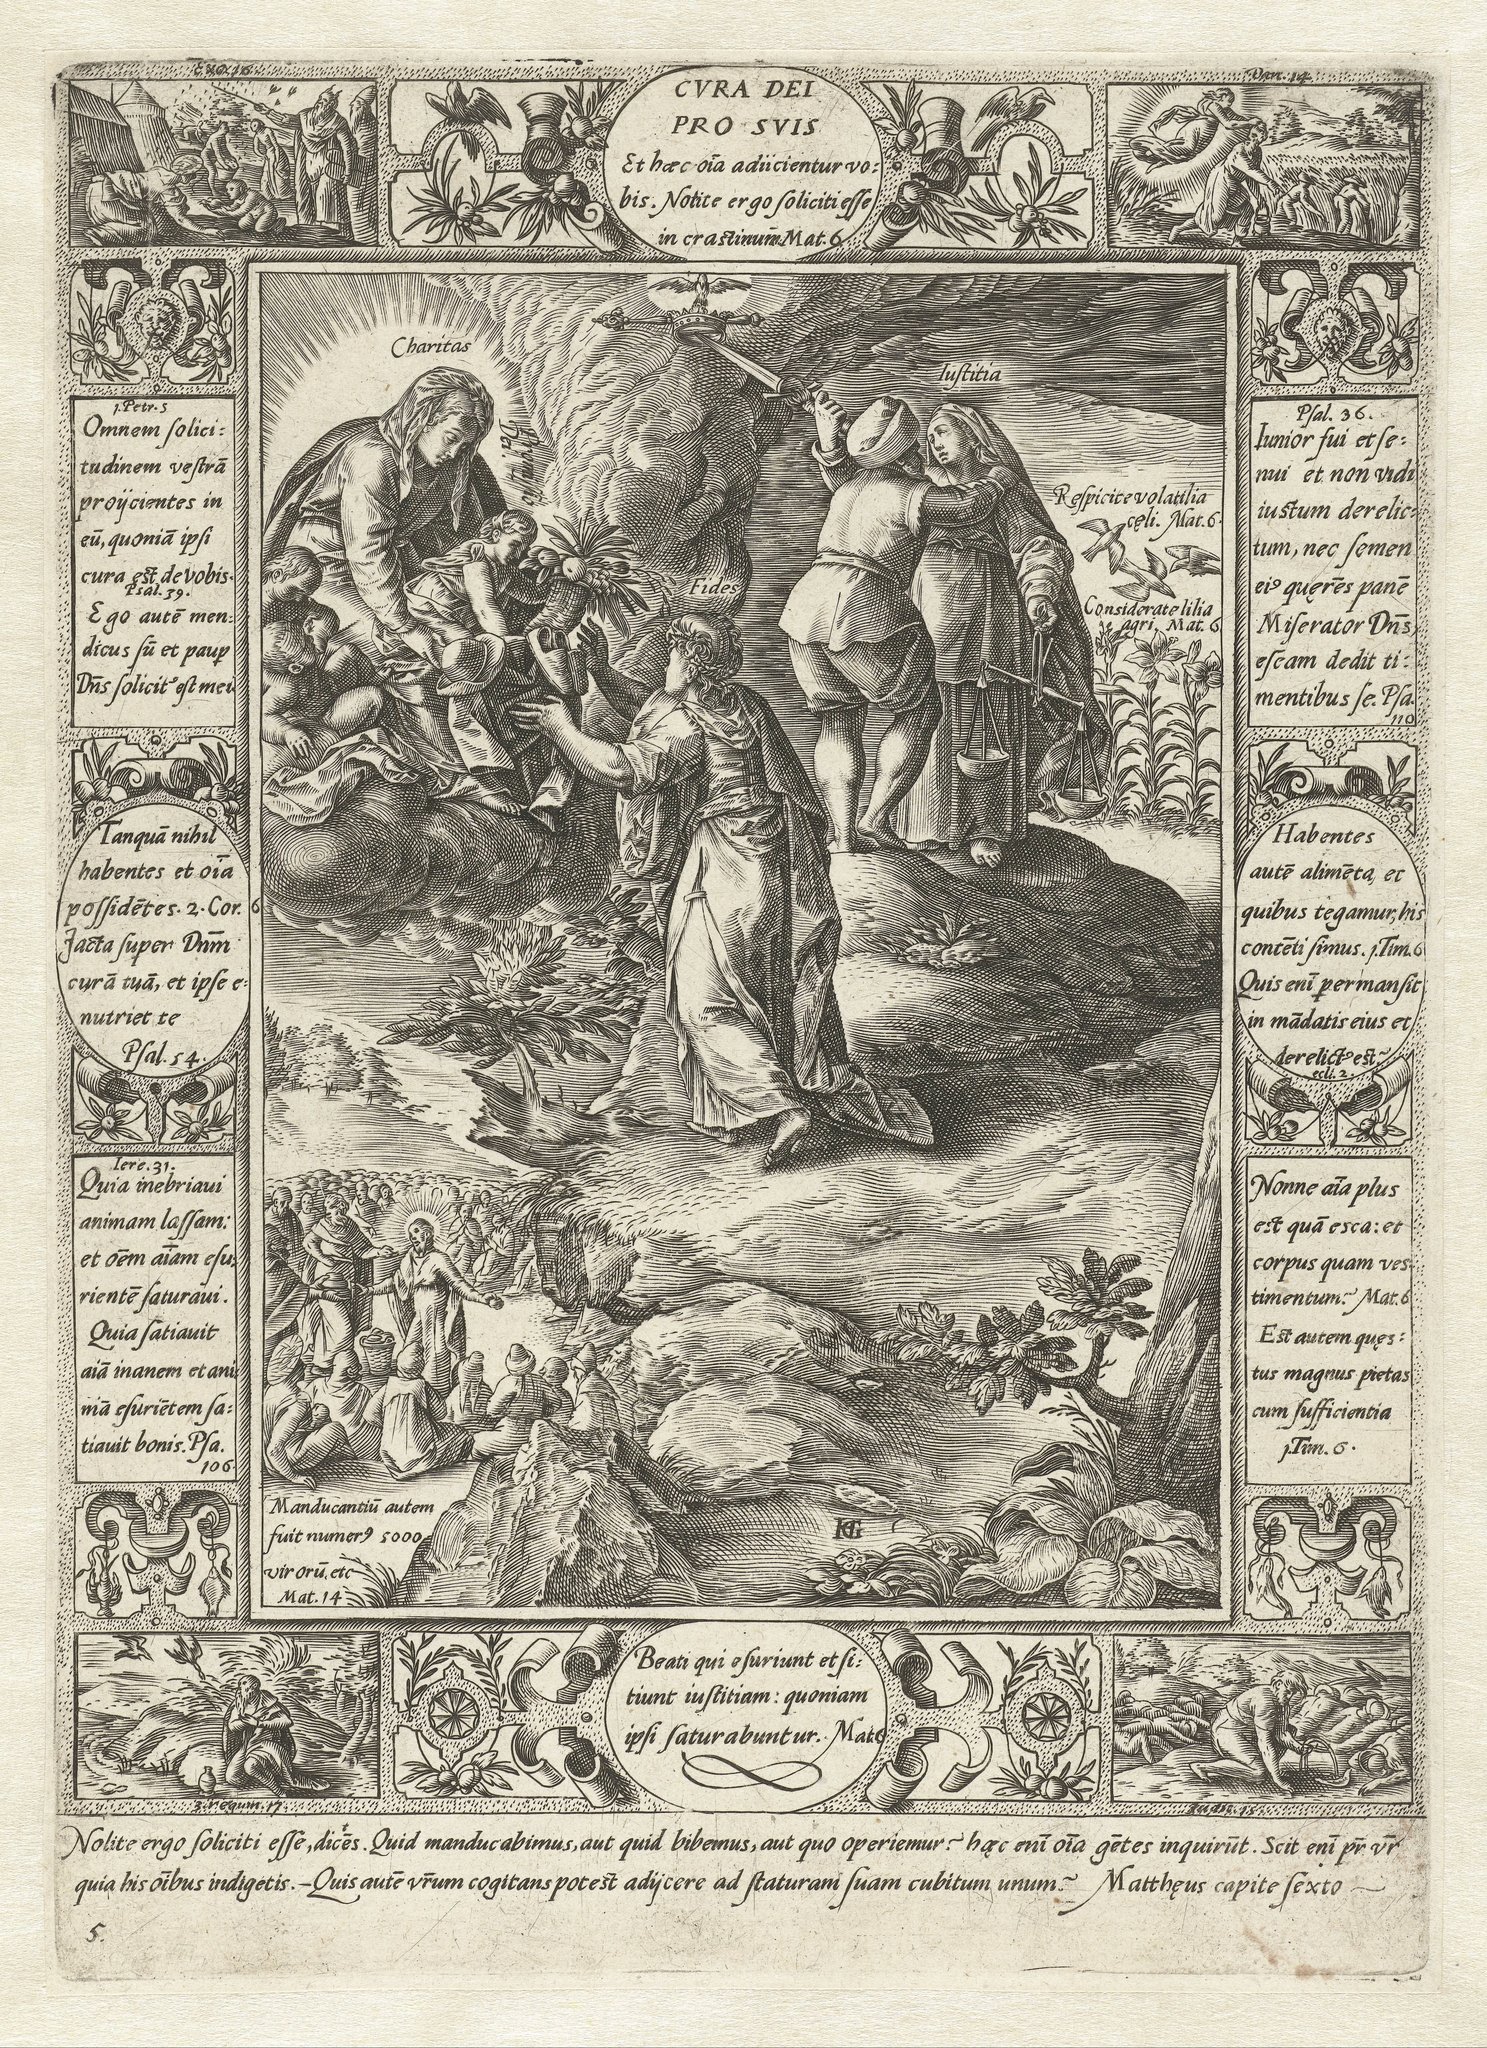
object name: print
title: Zorg van God voor de zijnen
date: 1598-1604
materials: paper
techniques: engraving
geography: the hague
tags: charity, 'caritas'; 'carità' (ripa) ~ one of the three theological virtues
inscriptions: collector's mark: Lugt 240, monogram: ‘HG’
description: Serie van tien (oorspronkelijk twaalf) allegorieën van het christelijke geloof. Elk van de allegorieën bestaat uit een centrale voorstelling met daaromheen een omlijsting waarin citaten uit de bijbel gecombineerd zijn met de verbeelding van bepaalde gebeurtenissen uit de bijbel. In de marge onderaan twee regels Latijn en het nummer 5.